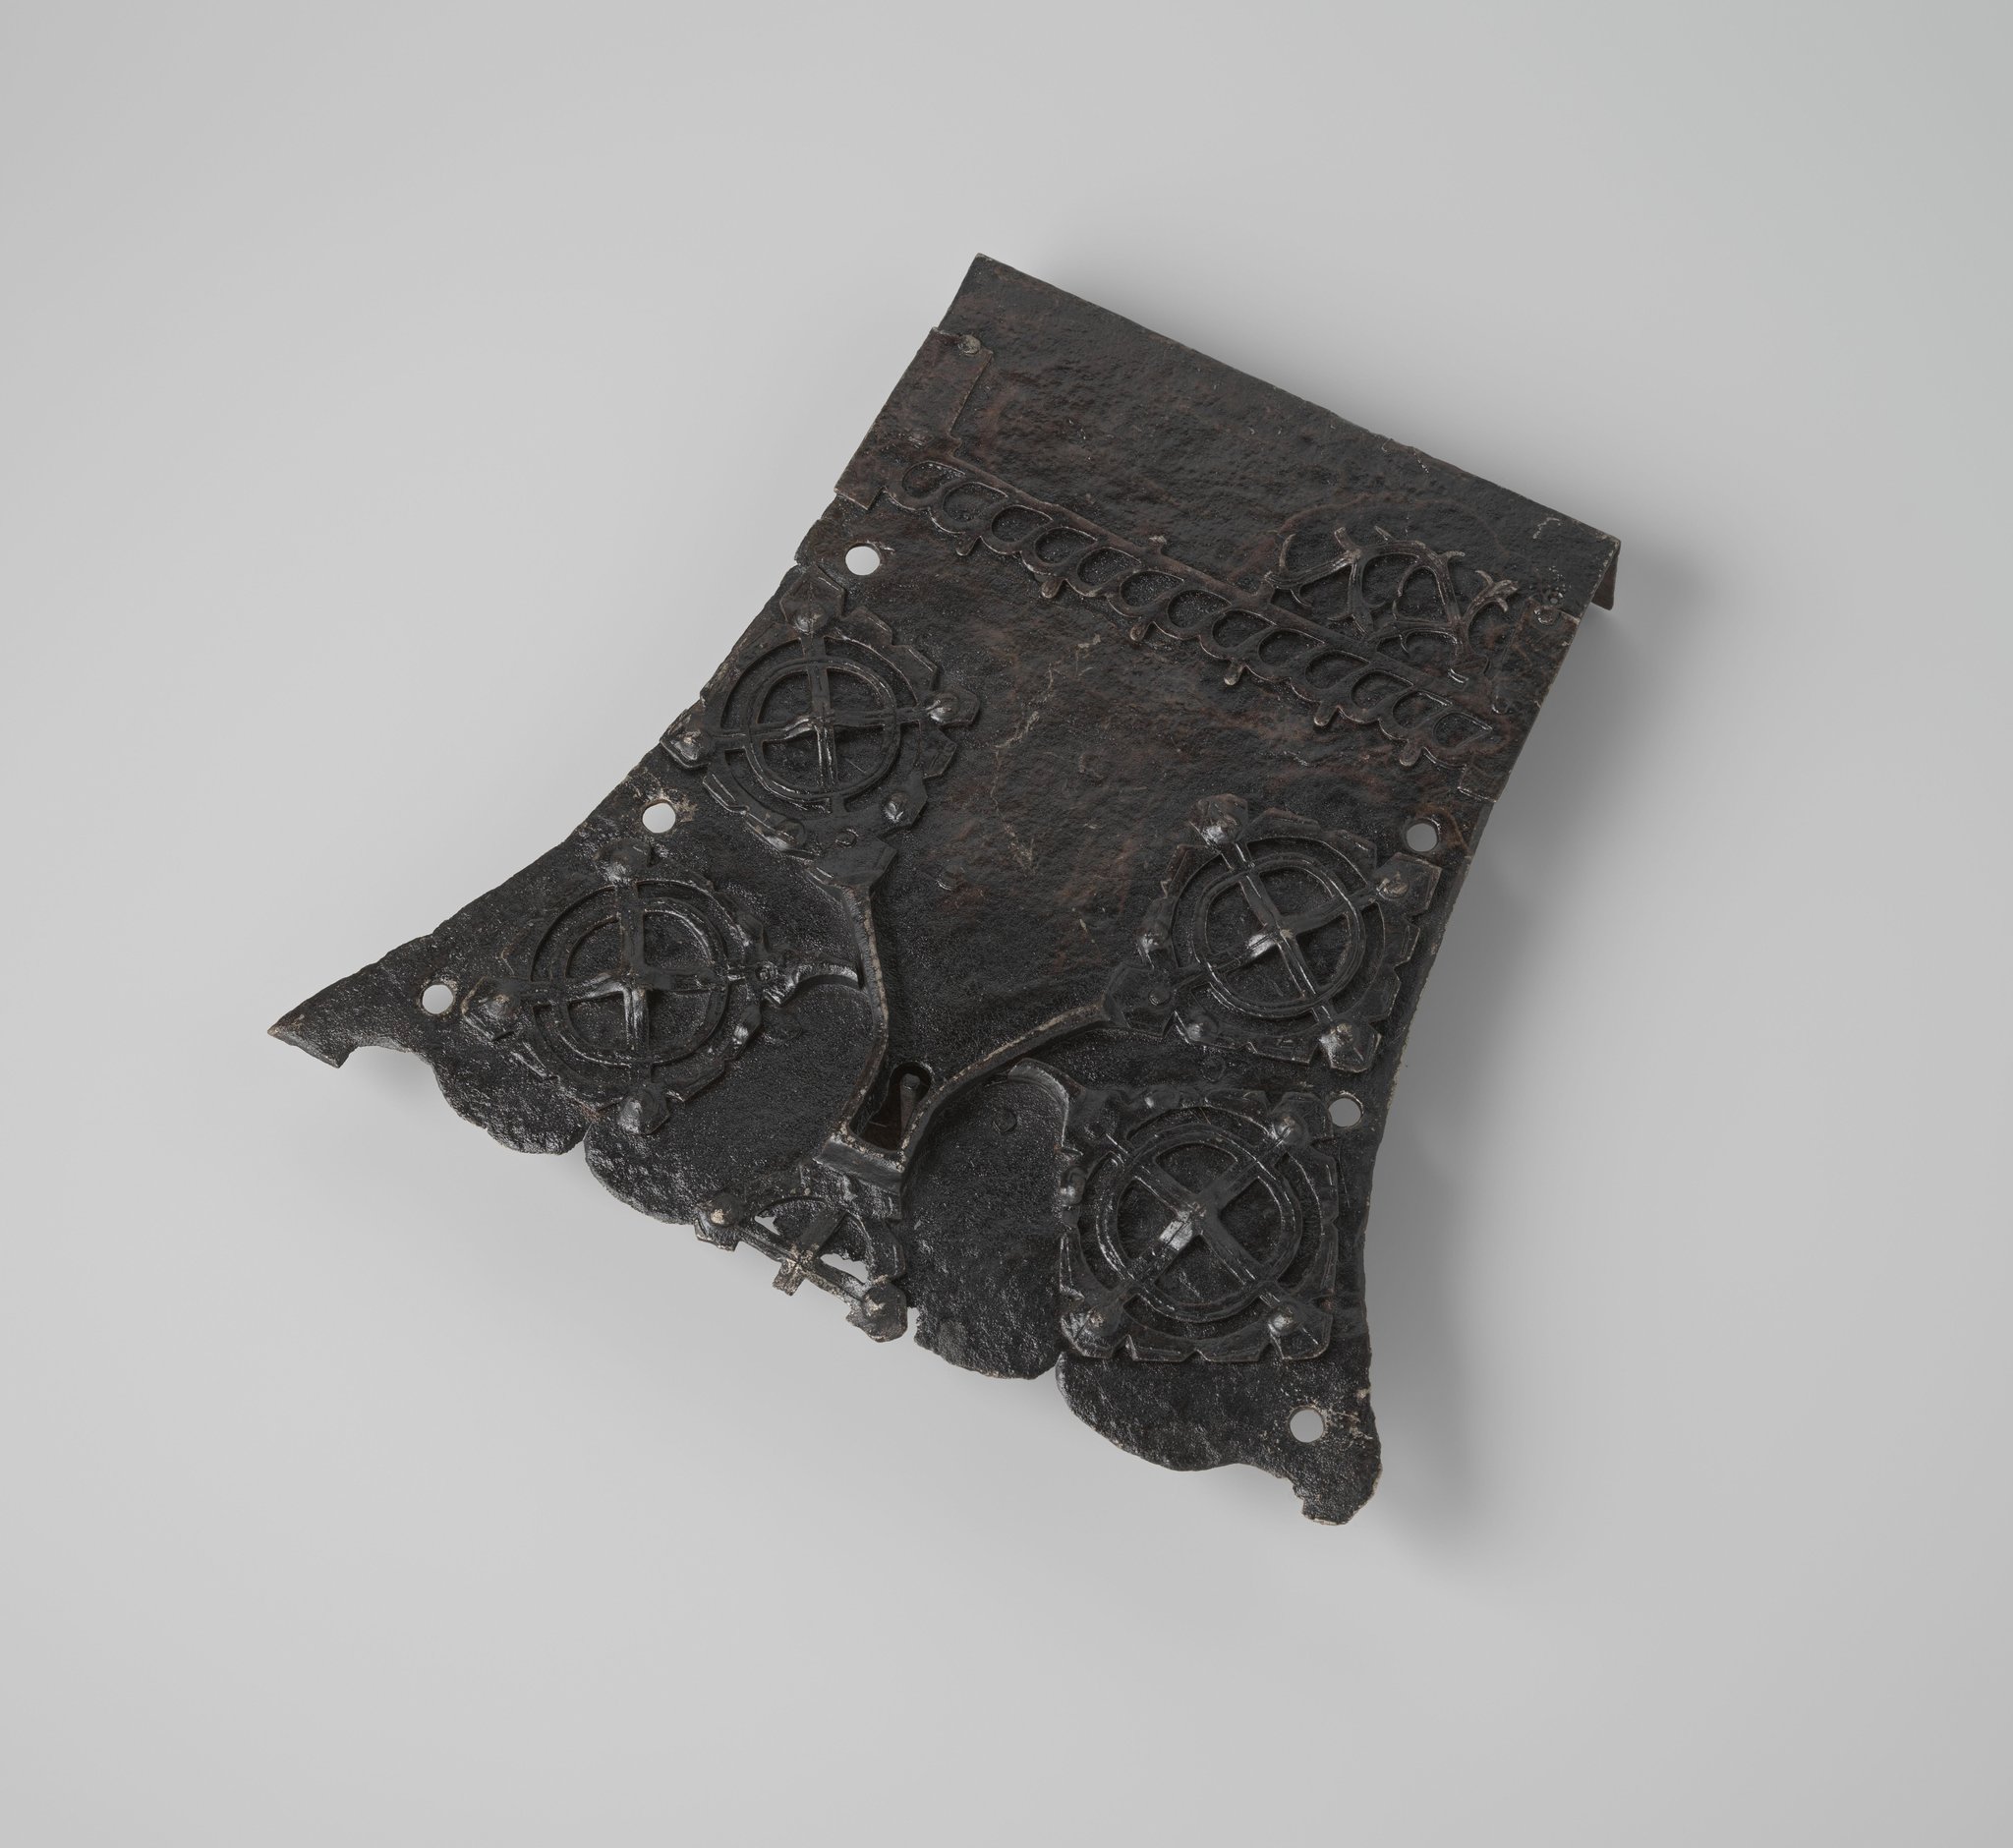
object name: door lock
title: Deurslot met plaat met gesmede ornamenten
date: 1475-1500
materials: iron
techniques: forging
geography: limburg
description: Een ijzeren deurslot met plaat, met gesmede ornamenten. Geschonden. Opmerking: afkomstig uit Weert.